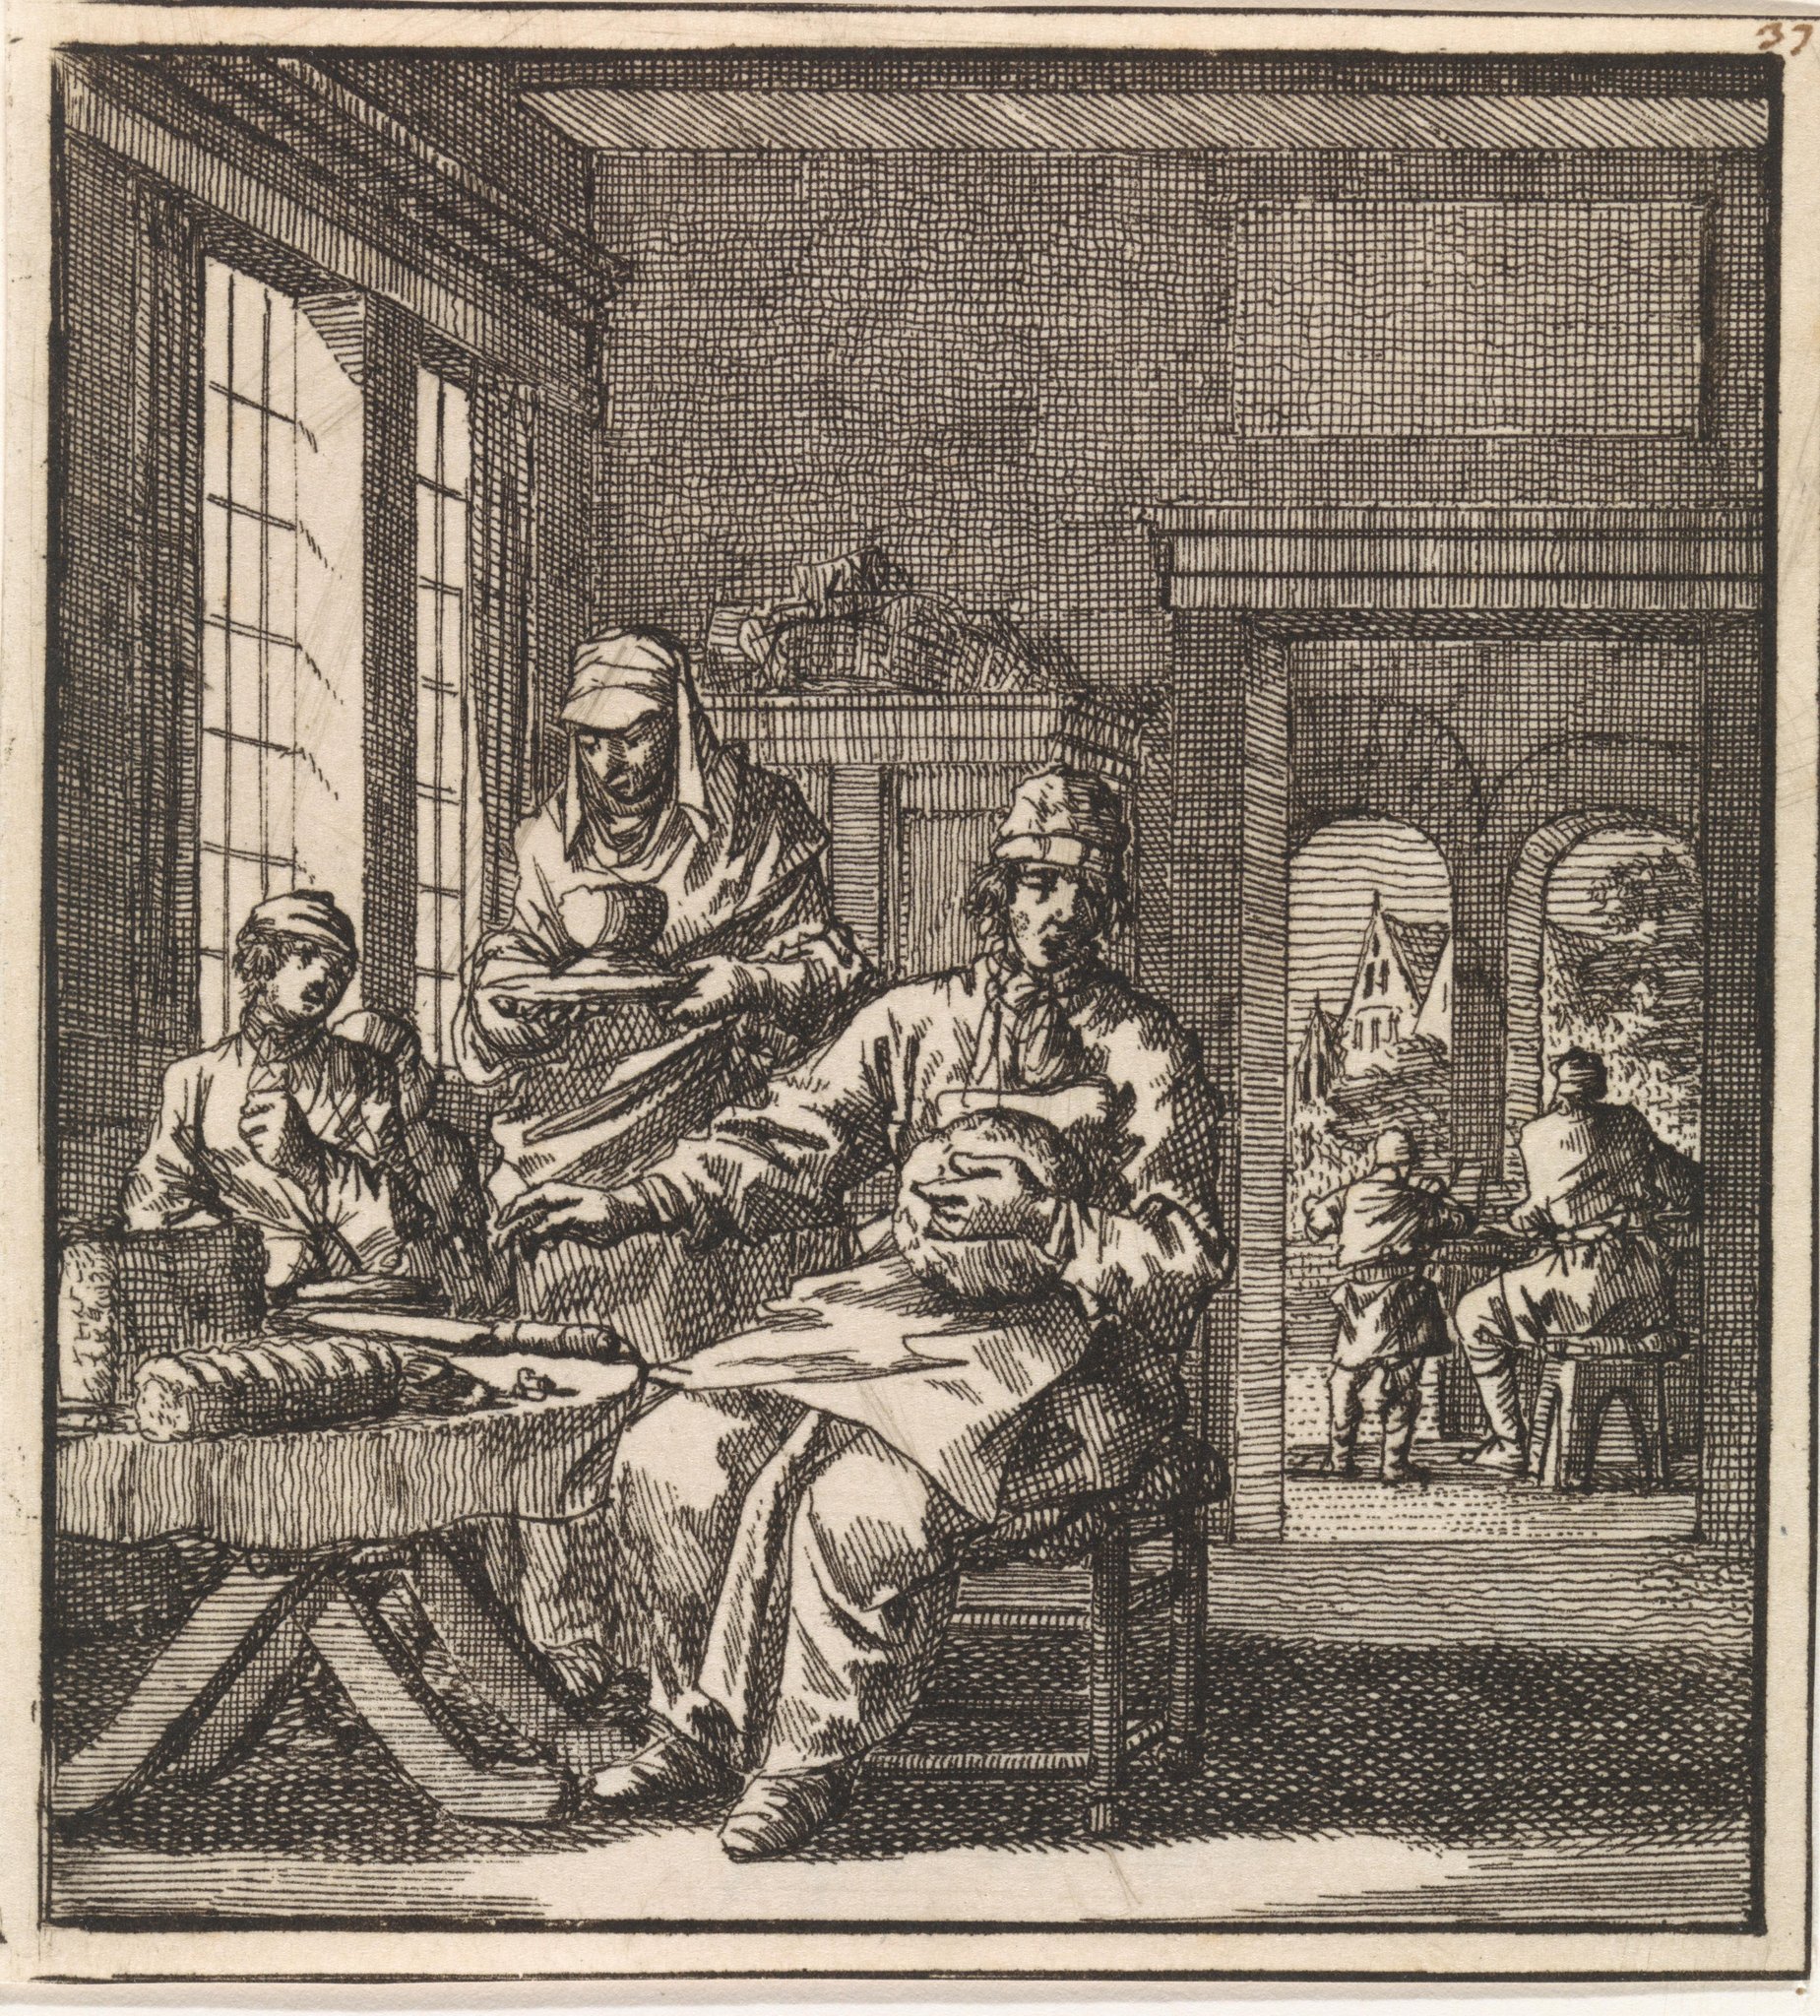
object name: print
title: Het Mes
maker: jan luyken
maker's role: draughtsman, print maker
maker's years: 1649-1712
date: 1711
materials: paper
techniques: etching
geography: amsterdam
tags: bread, loaf, tools, aids, implements ~ crafts and industries: knife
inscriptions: collector's mark: Lugt 2228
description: Proefdruk van illustratie voor: Luyken, Jan. Het leerzaam huisraad, vertoond in vyftig konstige figuuren, met godlyke spreuken en stichtelyke verzen: Pieter Arentsz. II (wed.) en Cornelis van der Sys, 1711, p. 130.